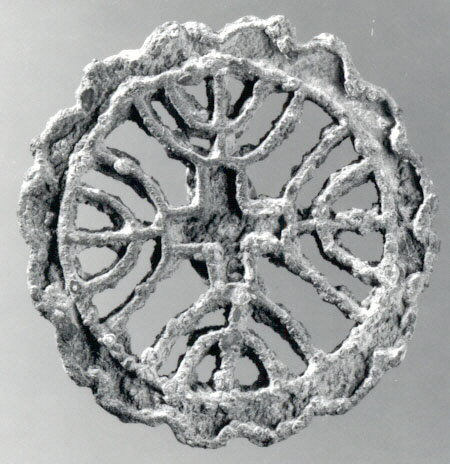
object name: stamp seal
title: Compartmented stamp seal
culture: bactria-margiana archaeological complex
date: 2333-1668 BCE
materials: copper alloy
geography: bactria-margiana